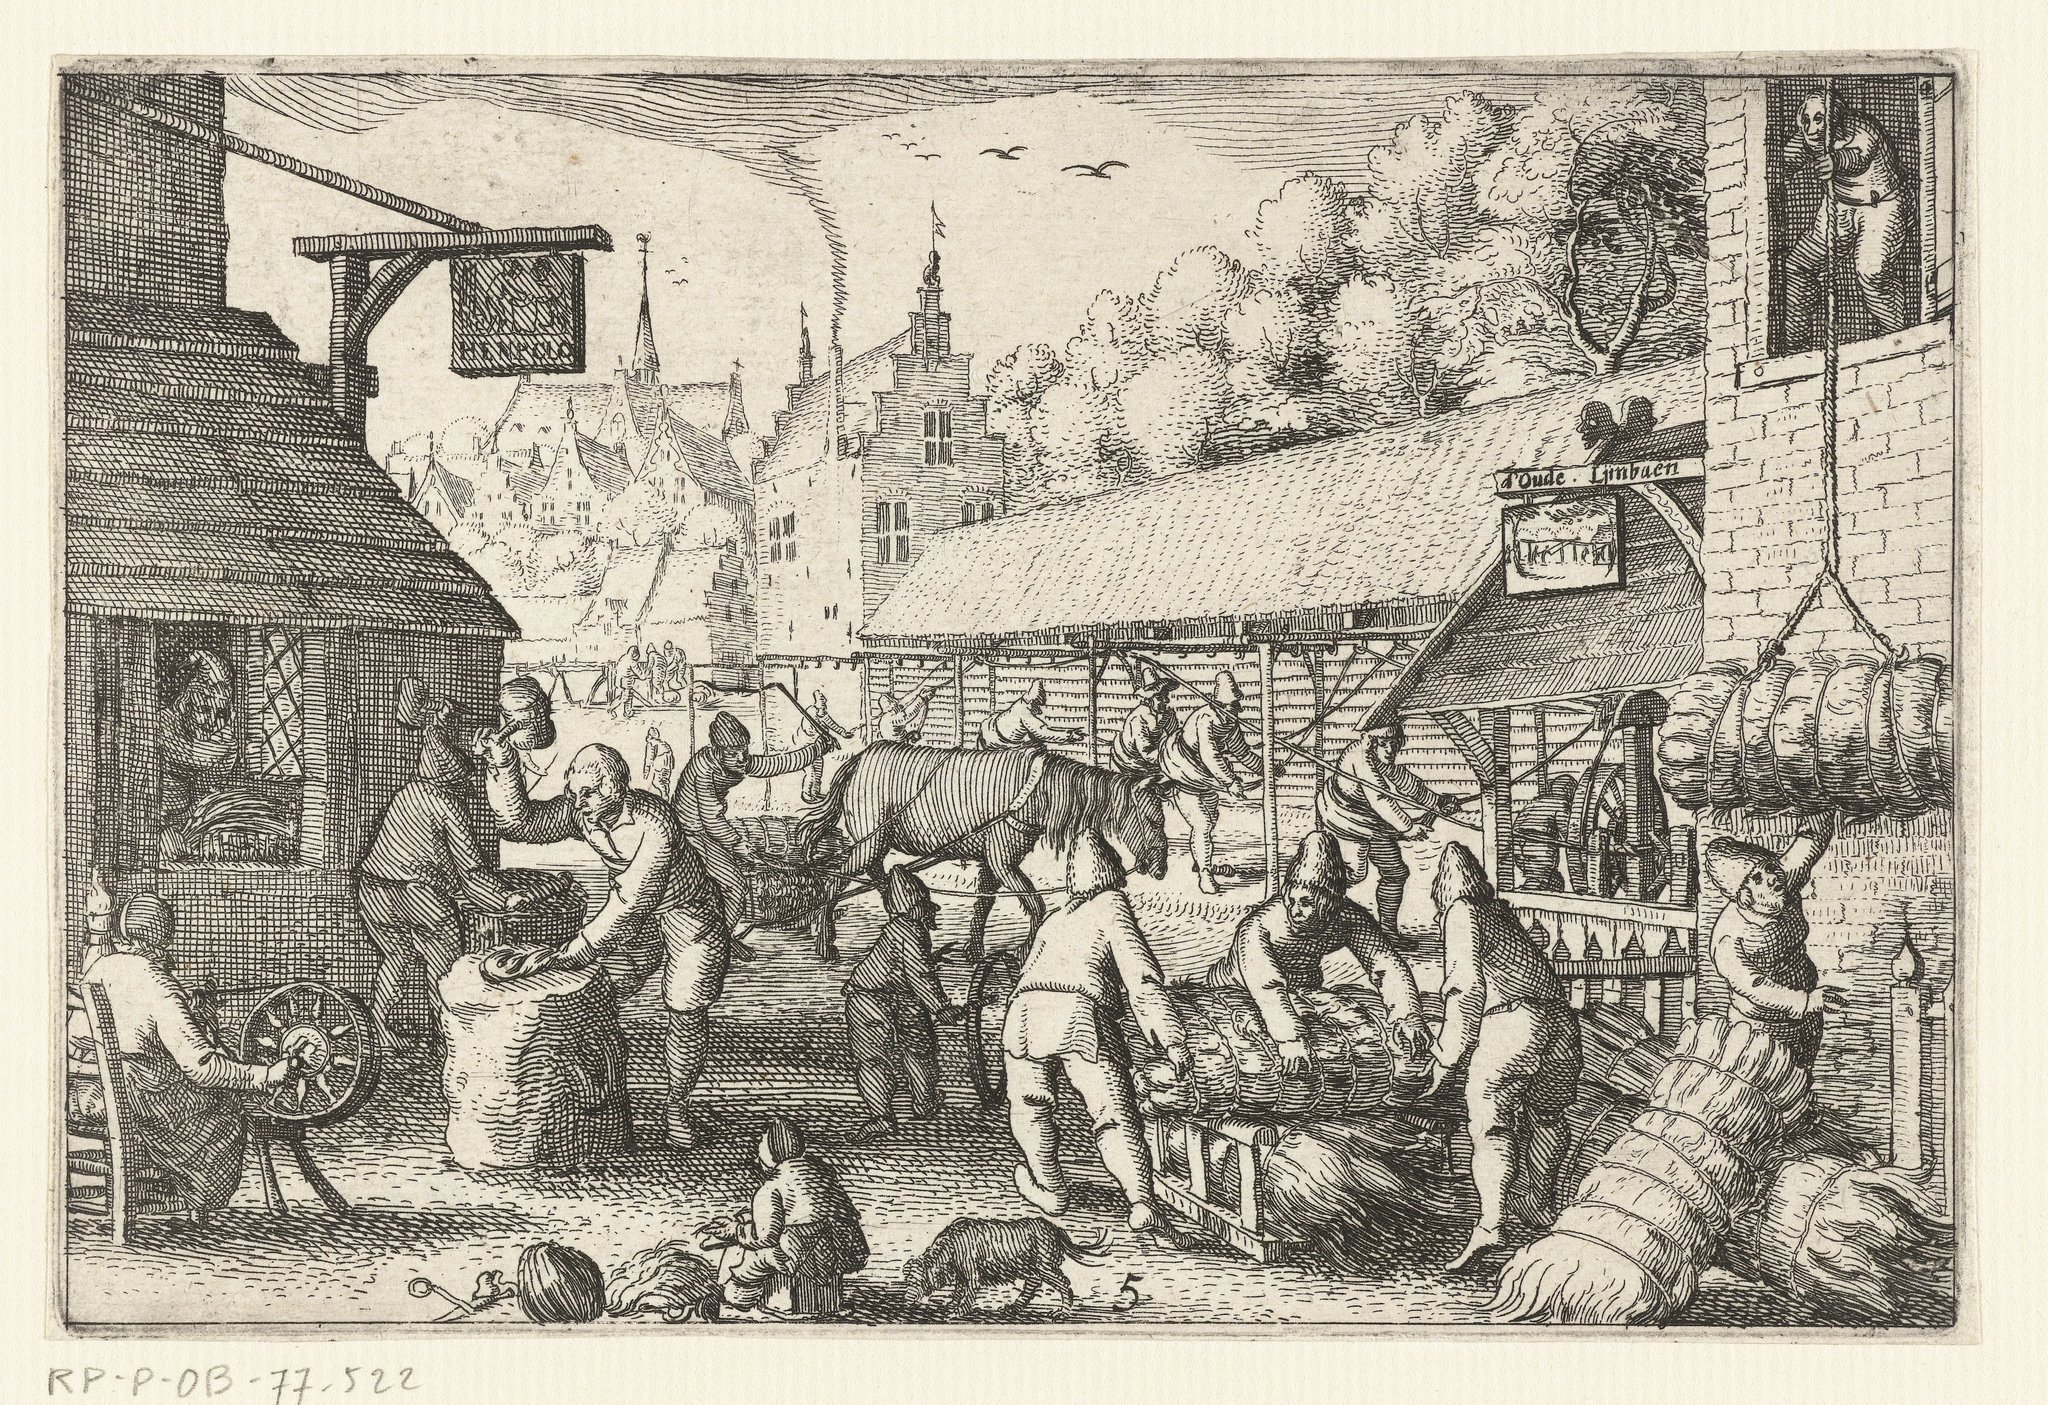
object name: print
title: Hennepindustrie en touwslagerij, ca. 1600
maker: claes jansz. visscher (ii)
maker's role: draughtsman, print maker, publisher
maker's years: 1586-1652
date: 1608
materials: paper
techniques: etching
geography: northern netherlands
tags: crafts and industries (+ fibre ~ crafts, industries, agriculture), ropery, rope-walk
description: Hennepindustrie en touwslagerij, ca. 1600. Rechts worden bundels hennep uitgeladen en getakeld. Links wordt de hennep geklopt en gesponnen. Op de achtergrond de lijnbaan van de touwslagerij. No. 5 uit serie beroepen in Noord-Holland.